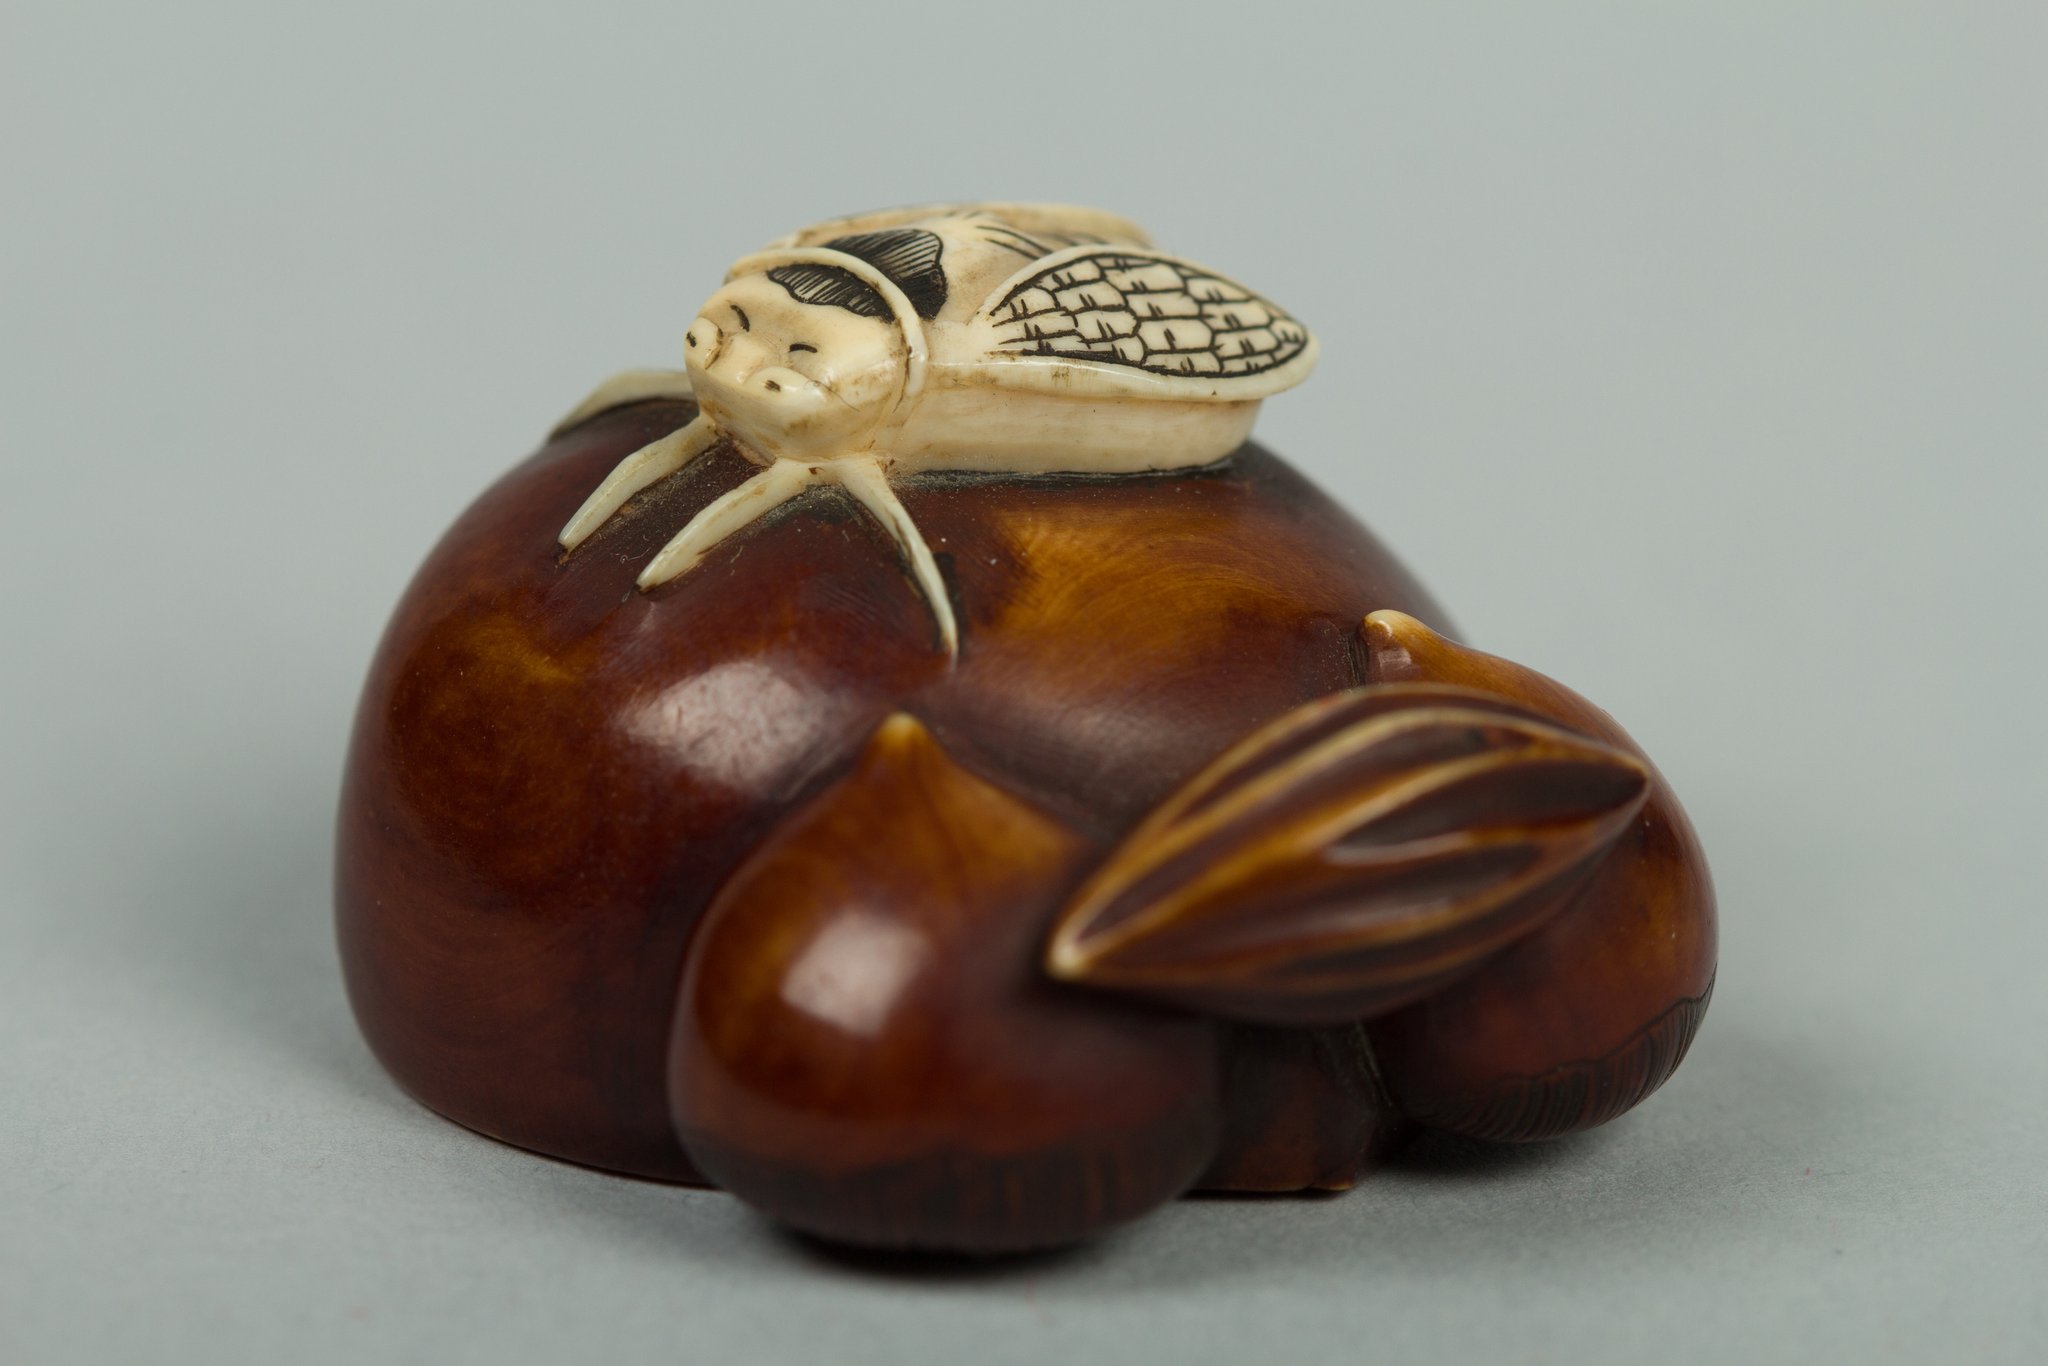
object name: netsuke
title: Netsuke of Chestnuts and a Fly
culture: japanese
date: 1801-1900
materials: ivory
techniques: stain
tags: fruit,insects